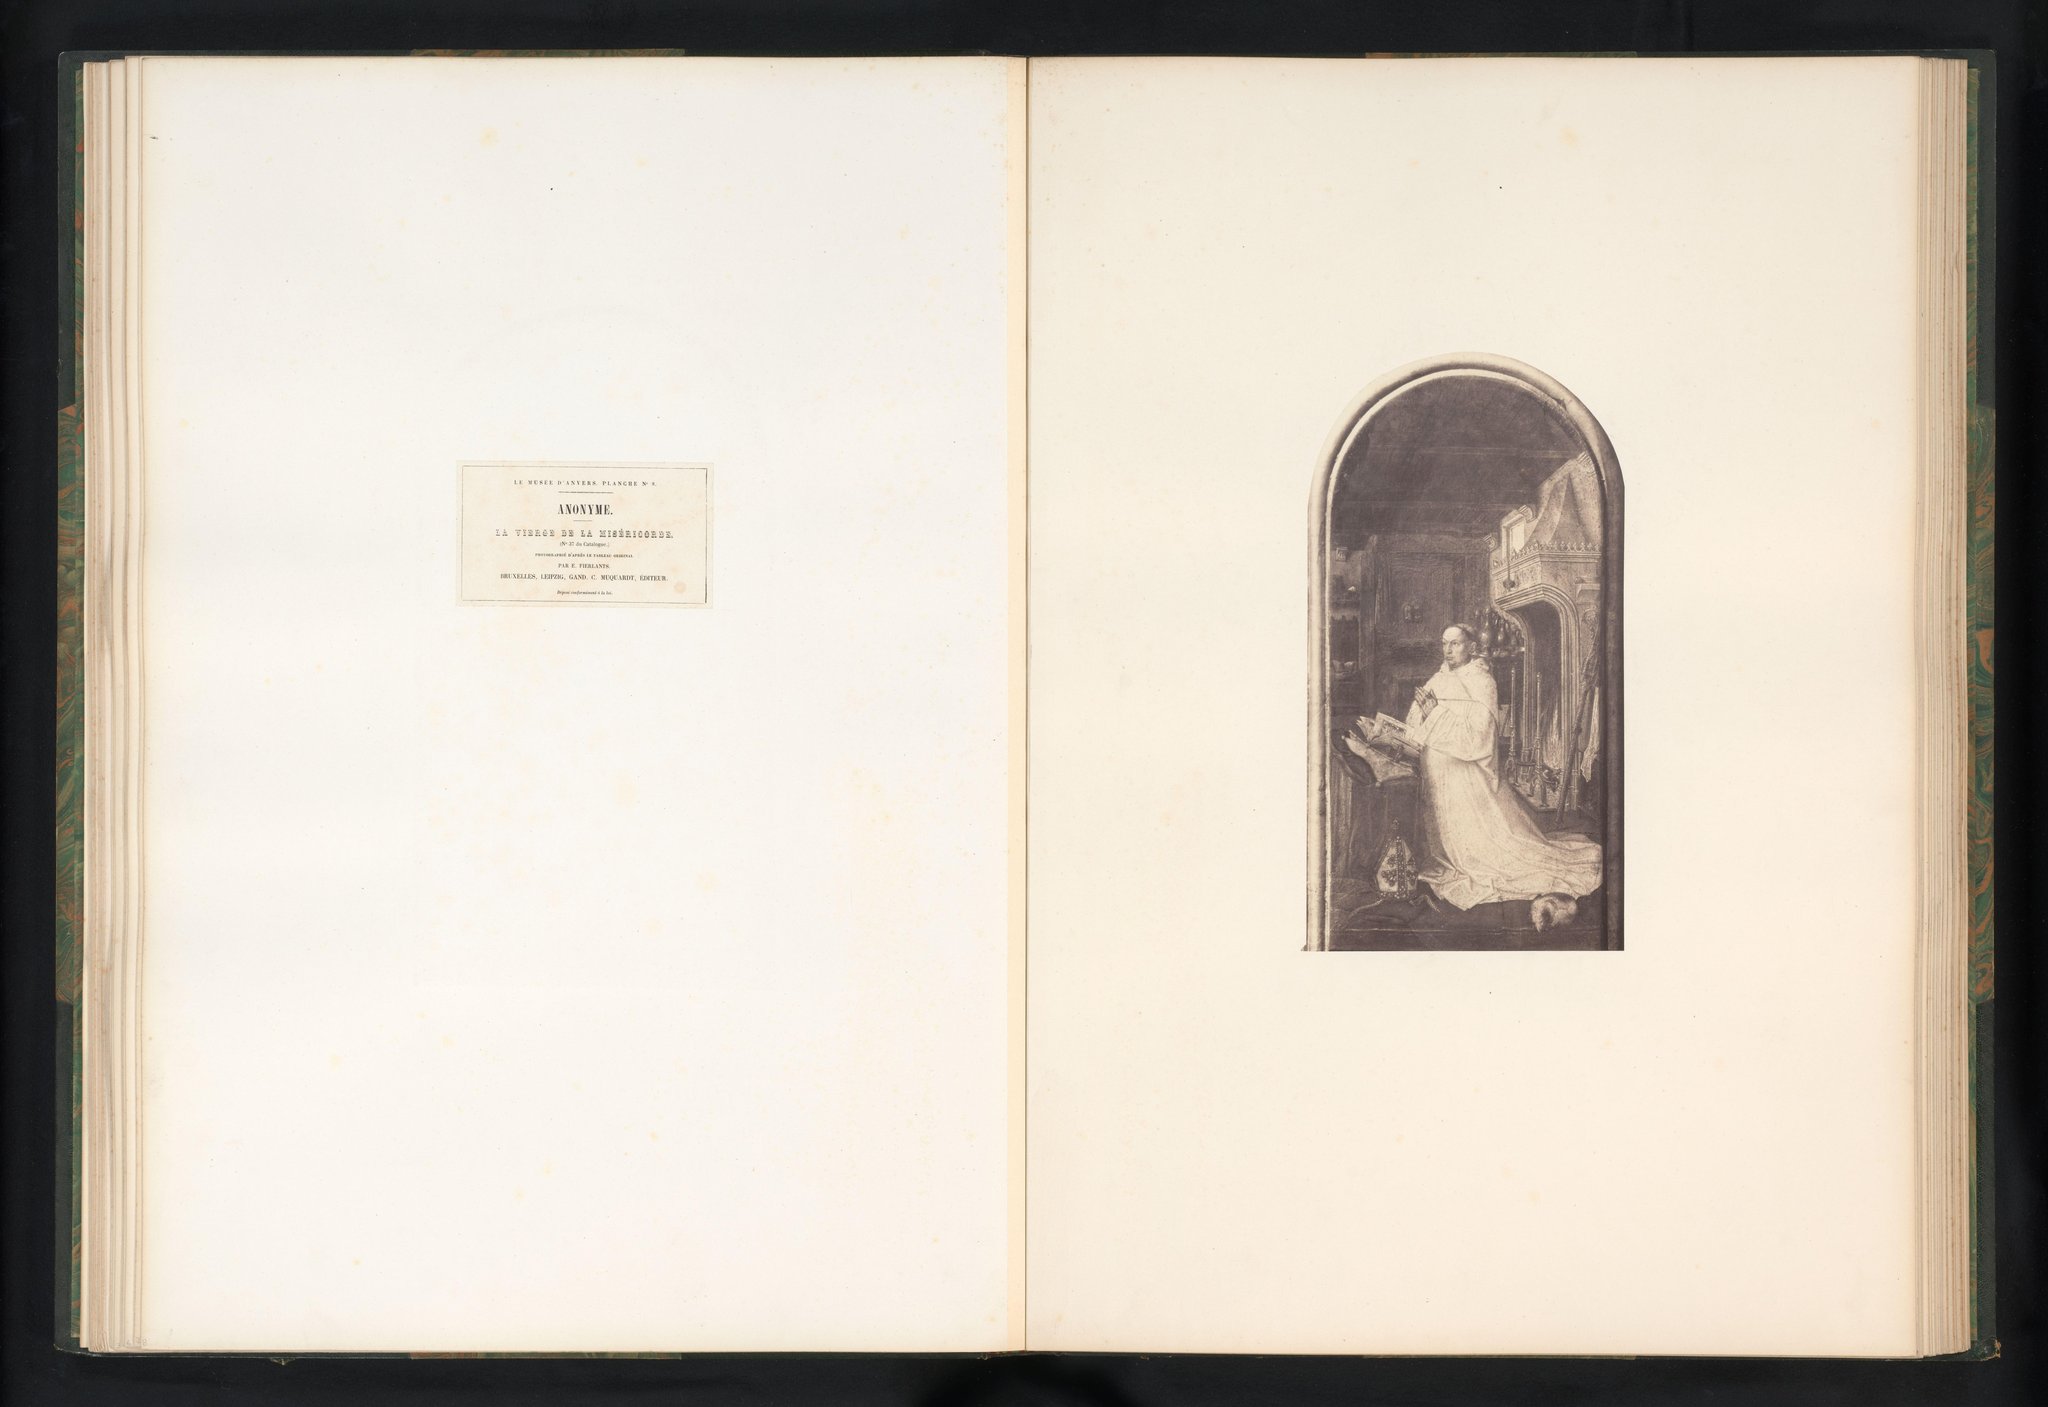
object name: photograph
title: Fotoreproductie van Christiaan de Hondt, abt van Ter Duinen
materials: photographic support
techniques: albumen print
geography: brussels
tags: monk(s), friar(s), one person praying